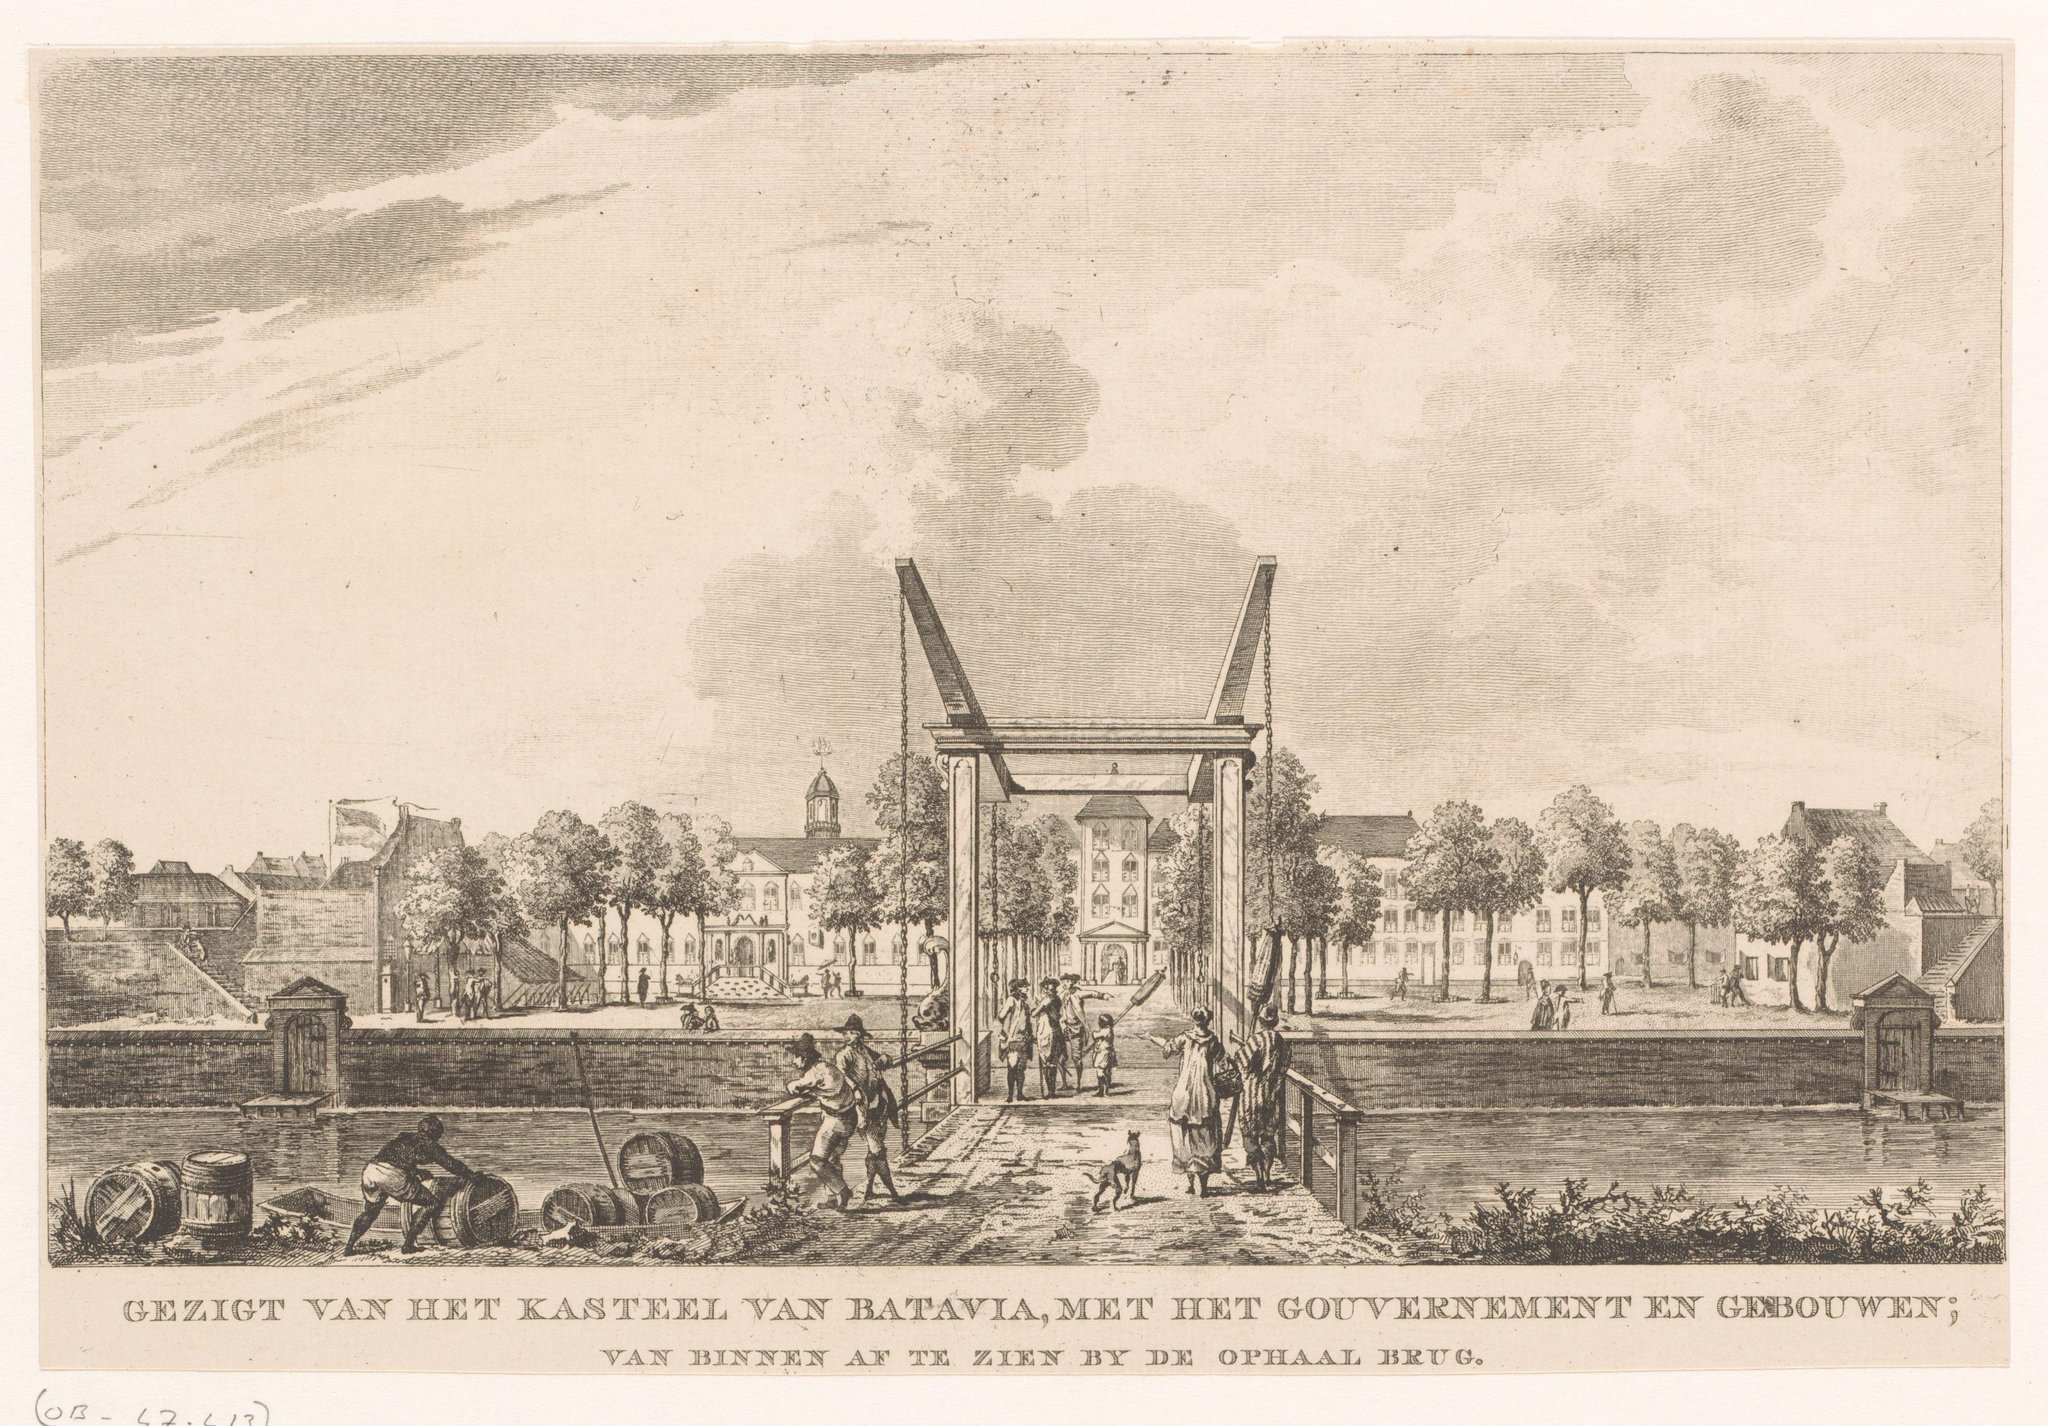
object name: book illustration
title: Gezicht op het gouverneurshuis te Batavia vanaf een ophaalbrug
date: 1781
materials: paper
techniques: engraving, etching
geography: rotterdam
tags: drawbridge ~ fortified city, bascule bridge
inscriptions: collector's mark: Lugt 2228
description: Mogelijk naar de tekening door Hendrik Kobell, coll. Rijksmuseum RP-T-FM-74. Prent uit: Verhandelingen van het Bataviaasch Genootschap der Kunsten en Wetenschappen. 61 dln. Rotterdam en Amsterdam: Reinier Arrenberg en Johannes Allart, 1781, dl. 1, p. 48.